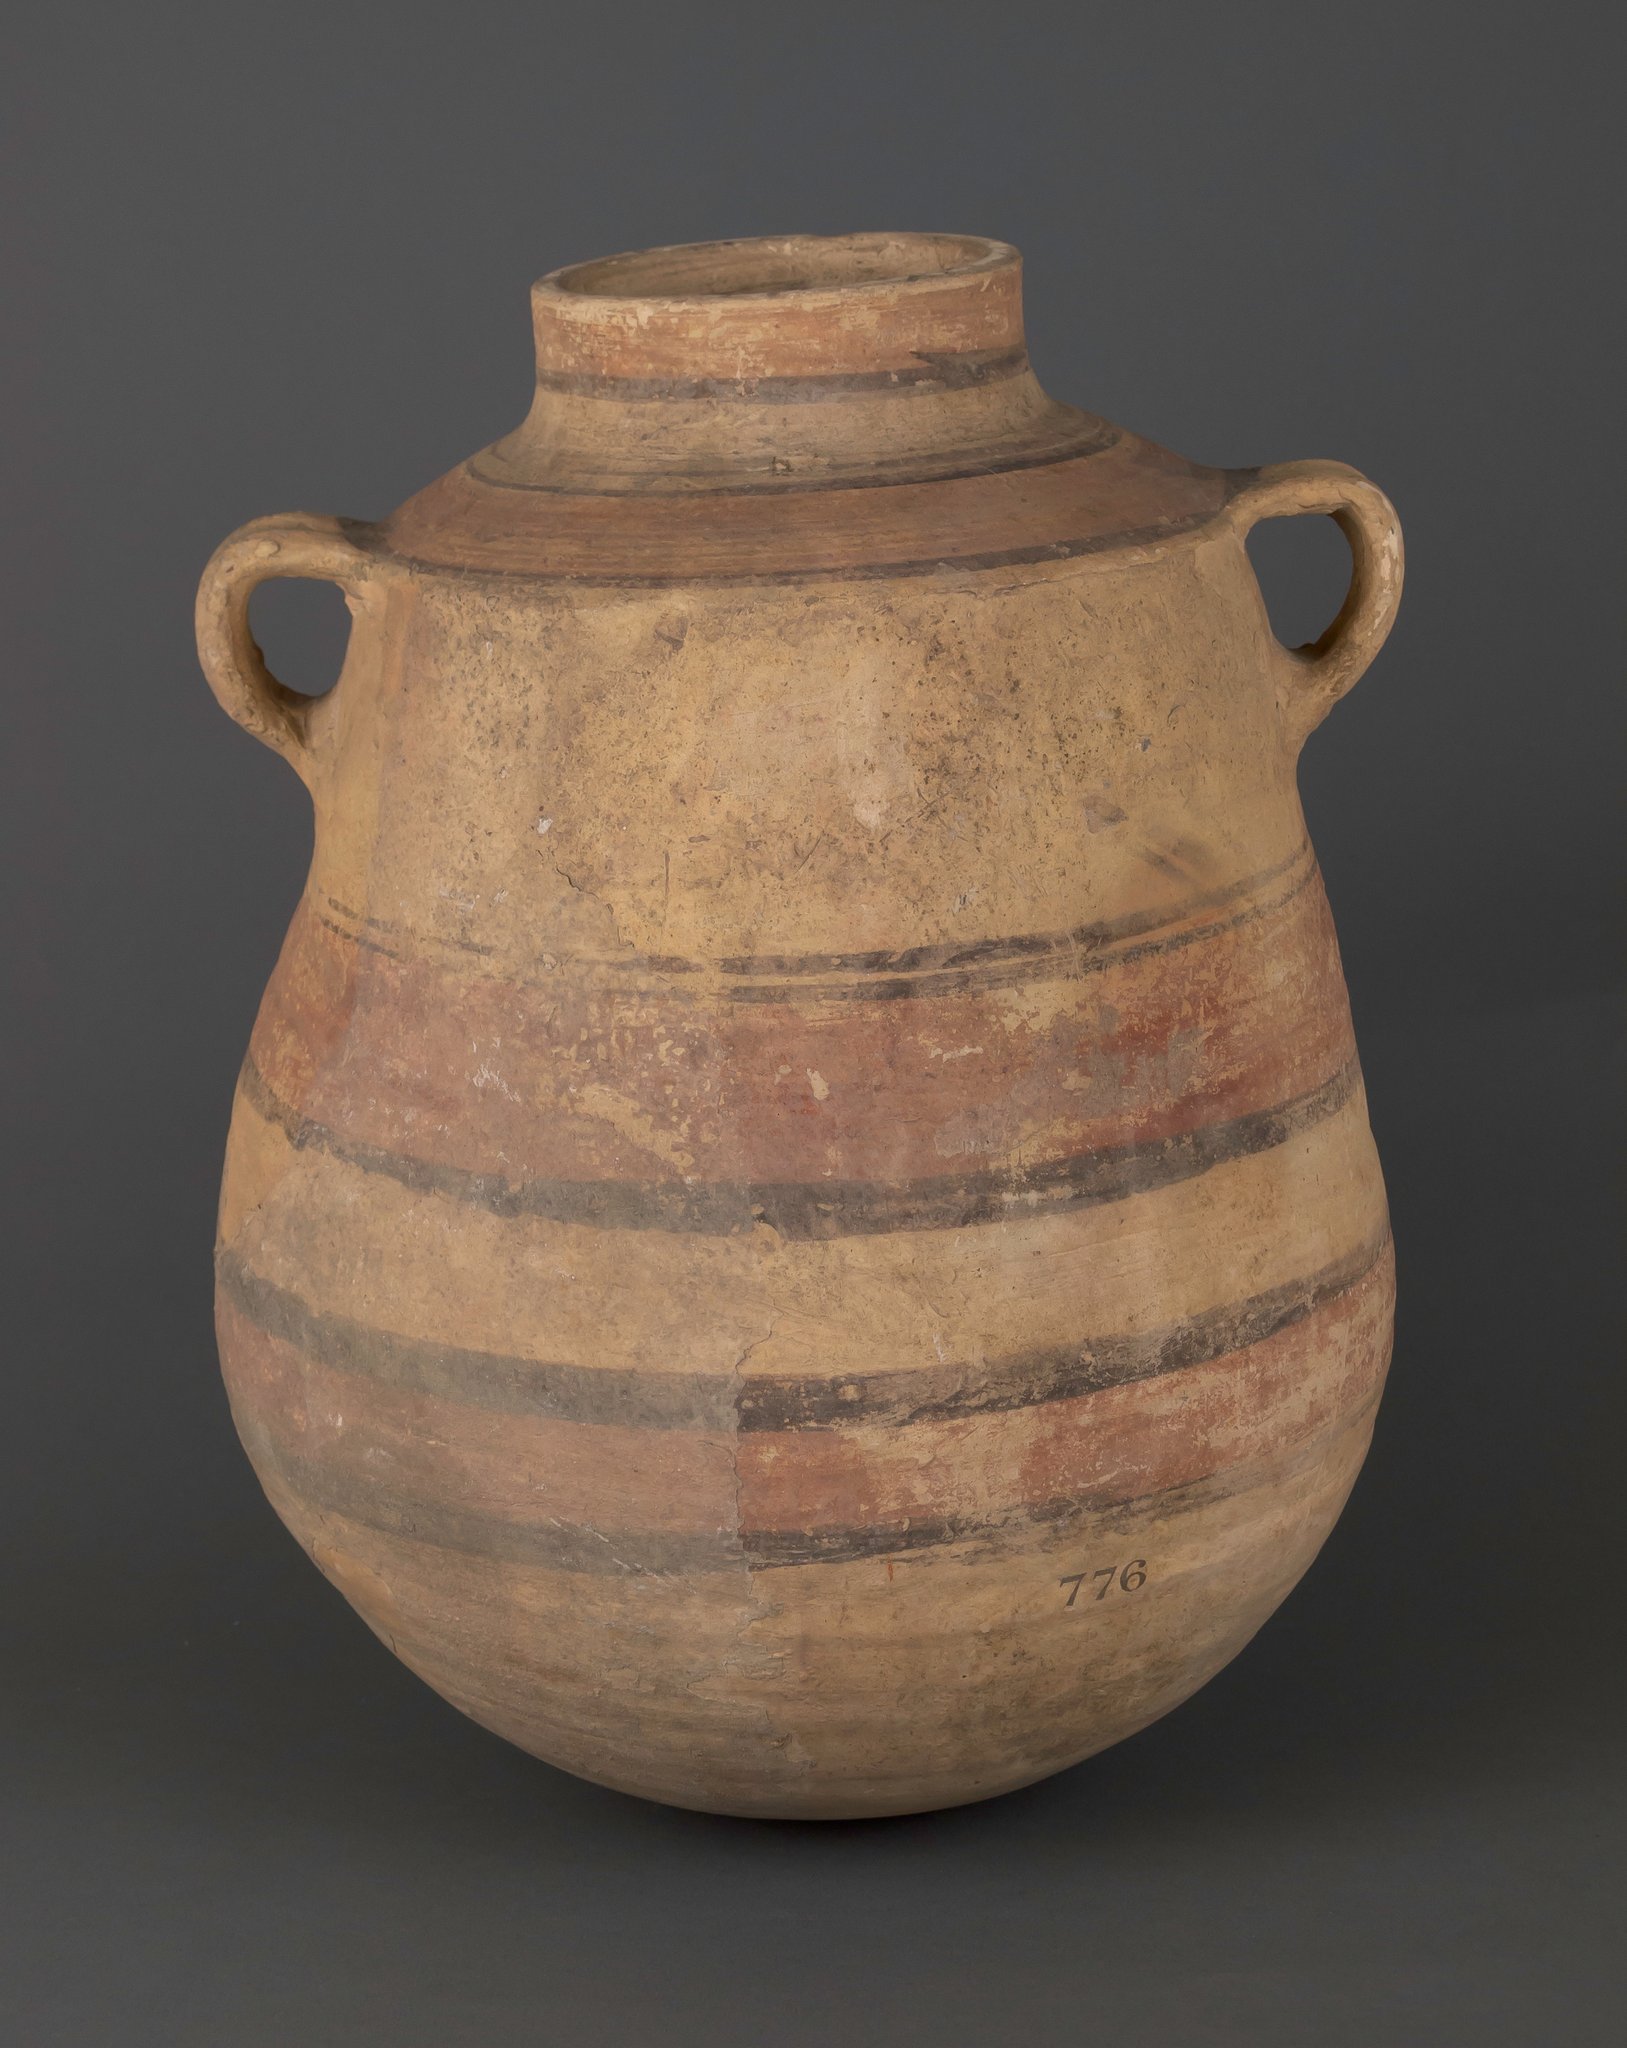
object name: jar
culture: cypriot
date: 507-323 BCE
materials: terracotta